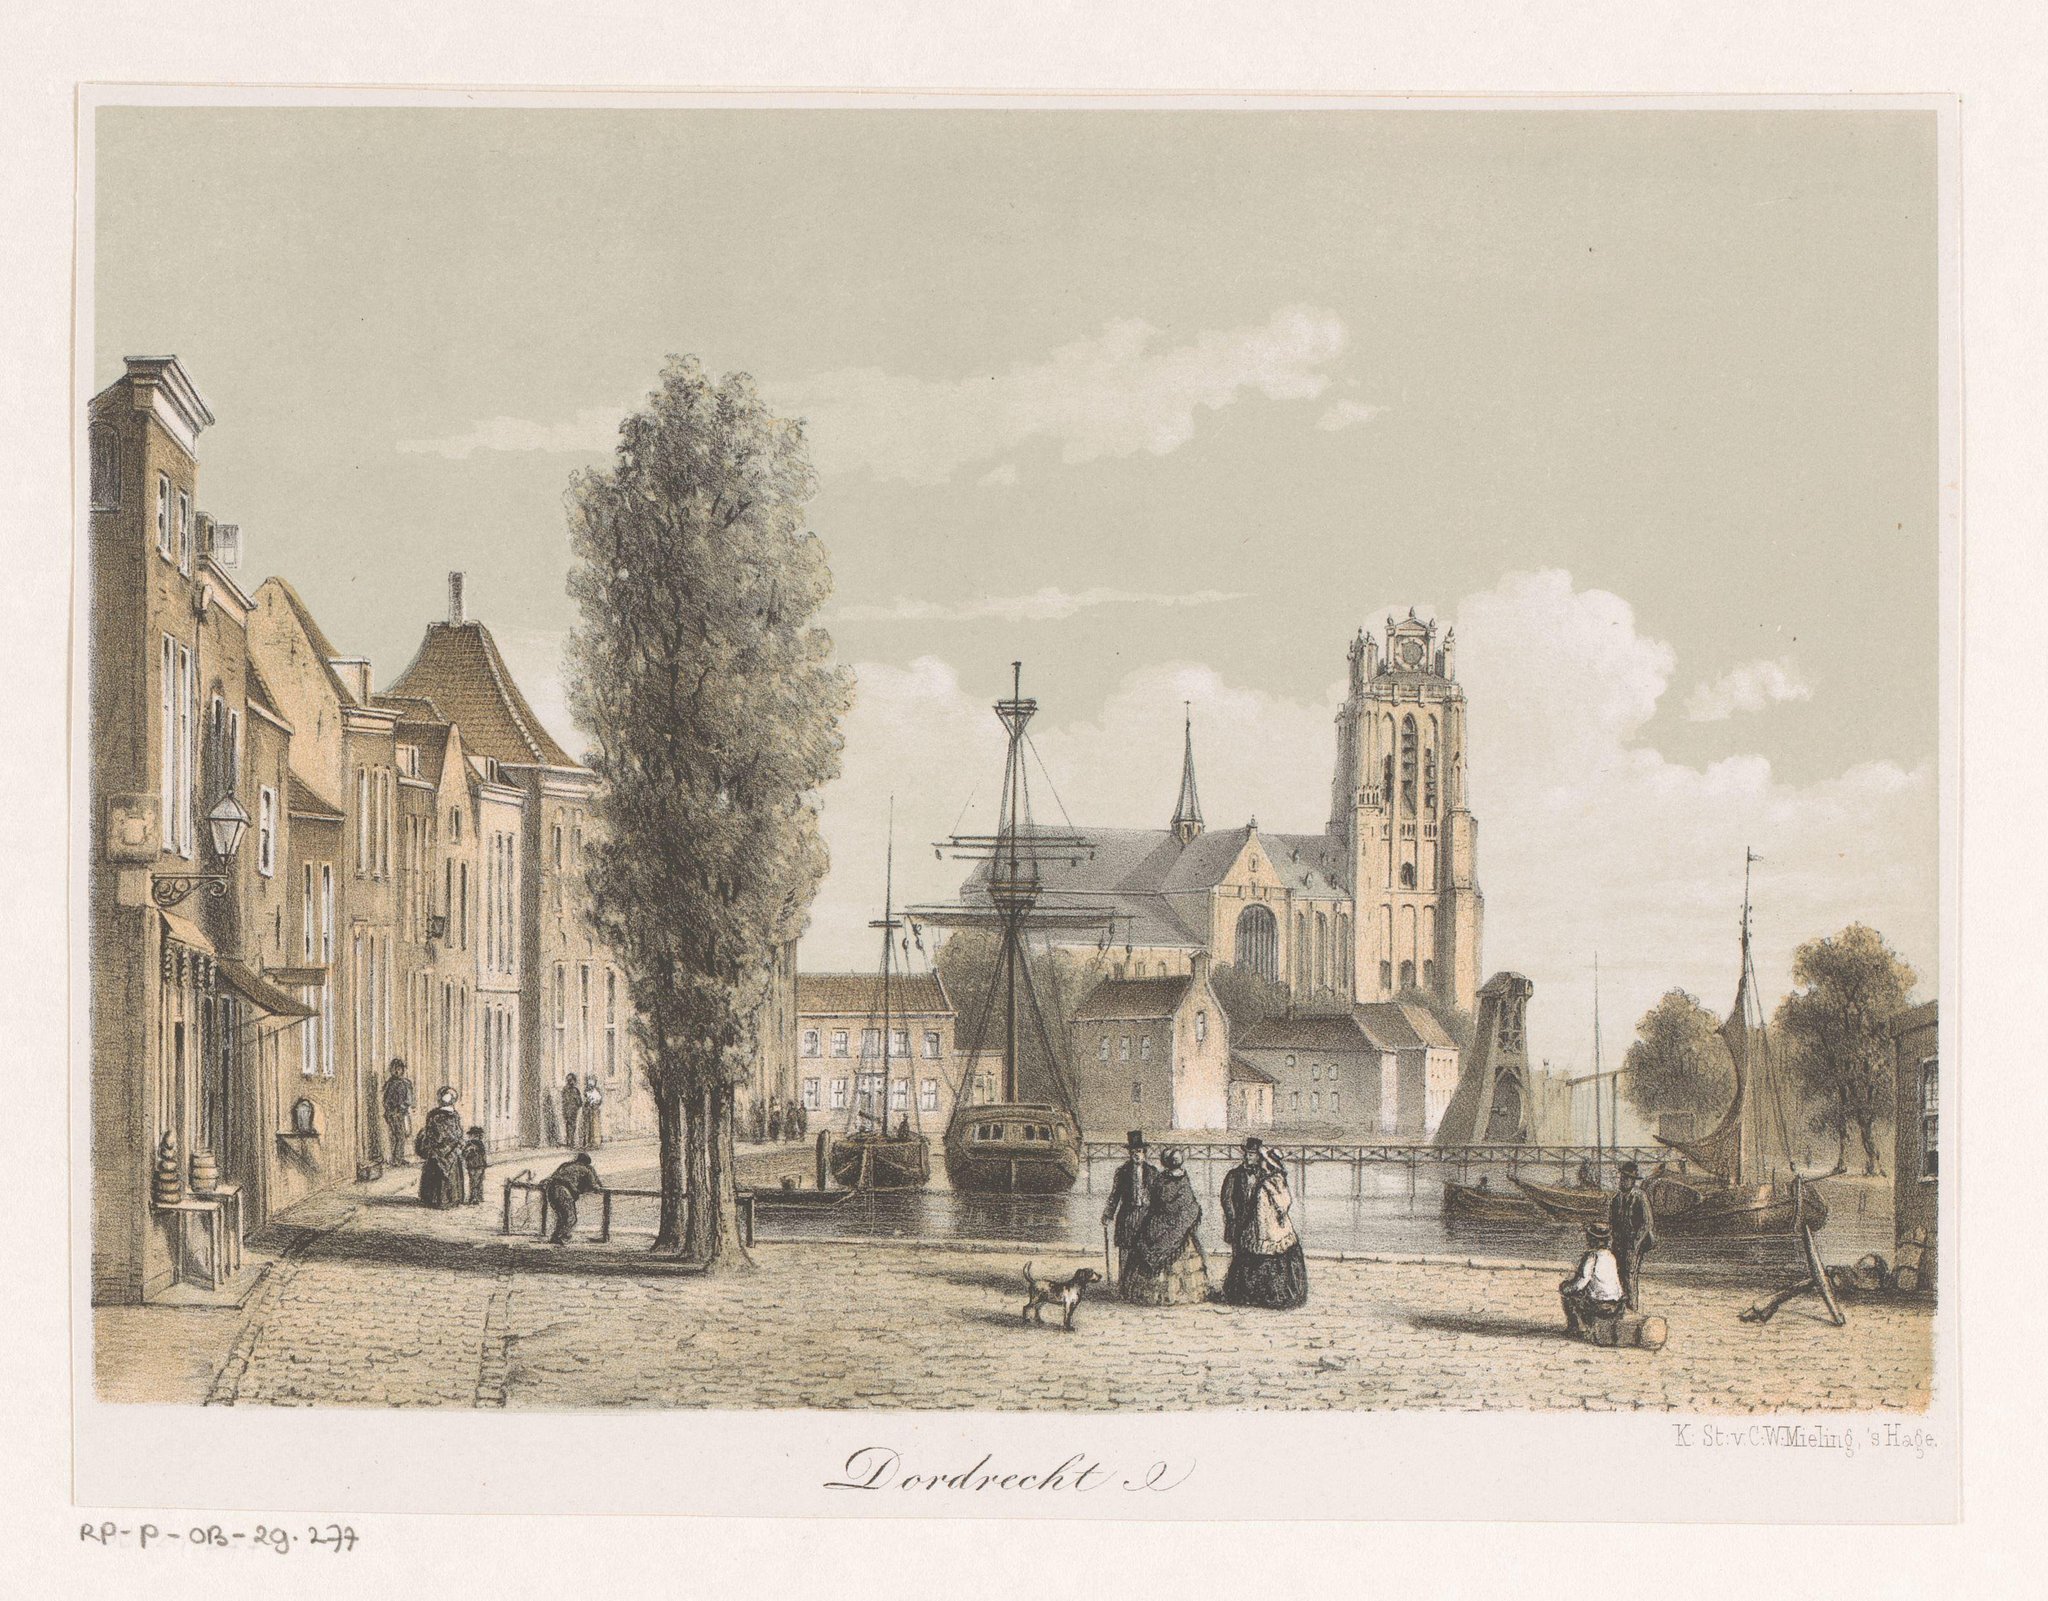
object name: print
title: Gezicht op de haven in Dordrecht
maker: Anonymous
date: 1863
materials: paper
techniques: tone lithography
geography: the hague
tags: bridge in city across river, canal, etc. (+ city(-scape) with figures, staffage), church (exterior), dordrecht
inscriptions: collector's mark: Lugt 2228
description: Achter de haven de Grote Kerk. Over het water loopt de Lange IJzeren Brug.